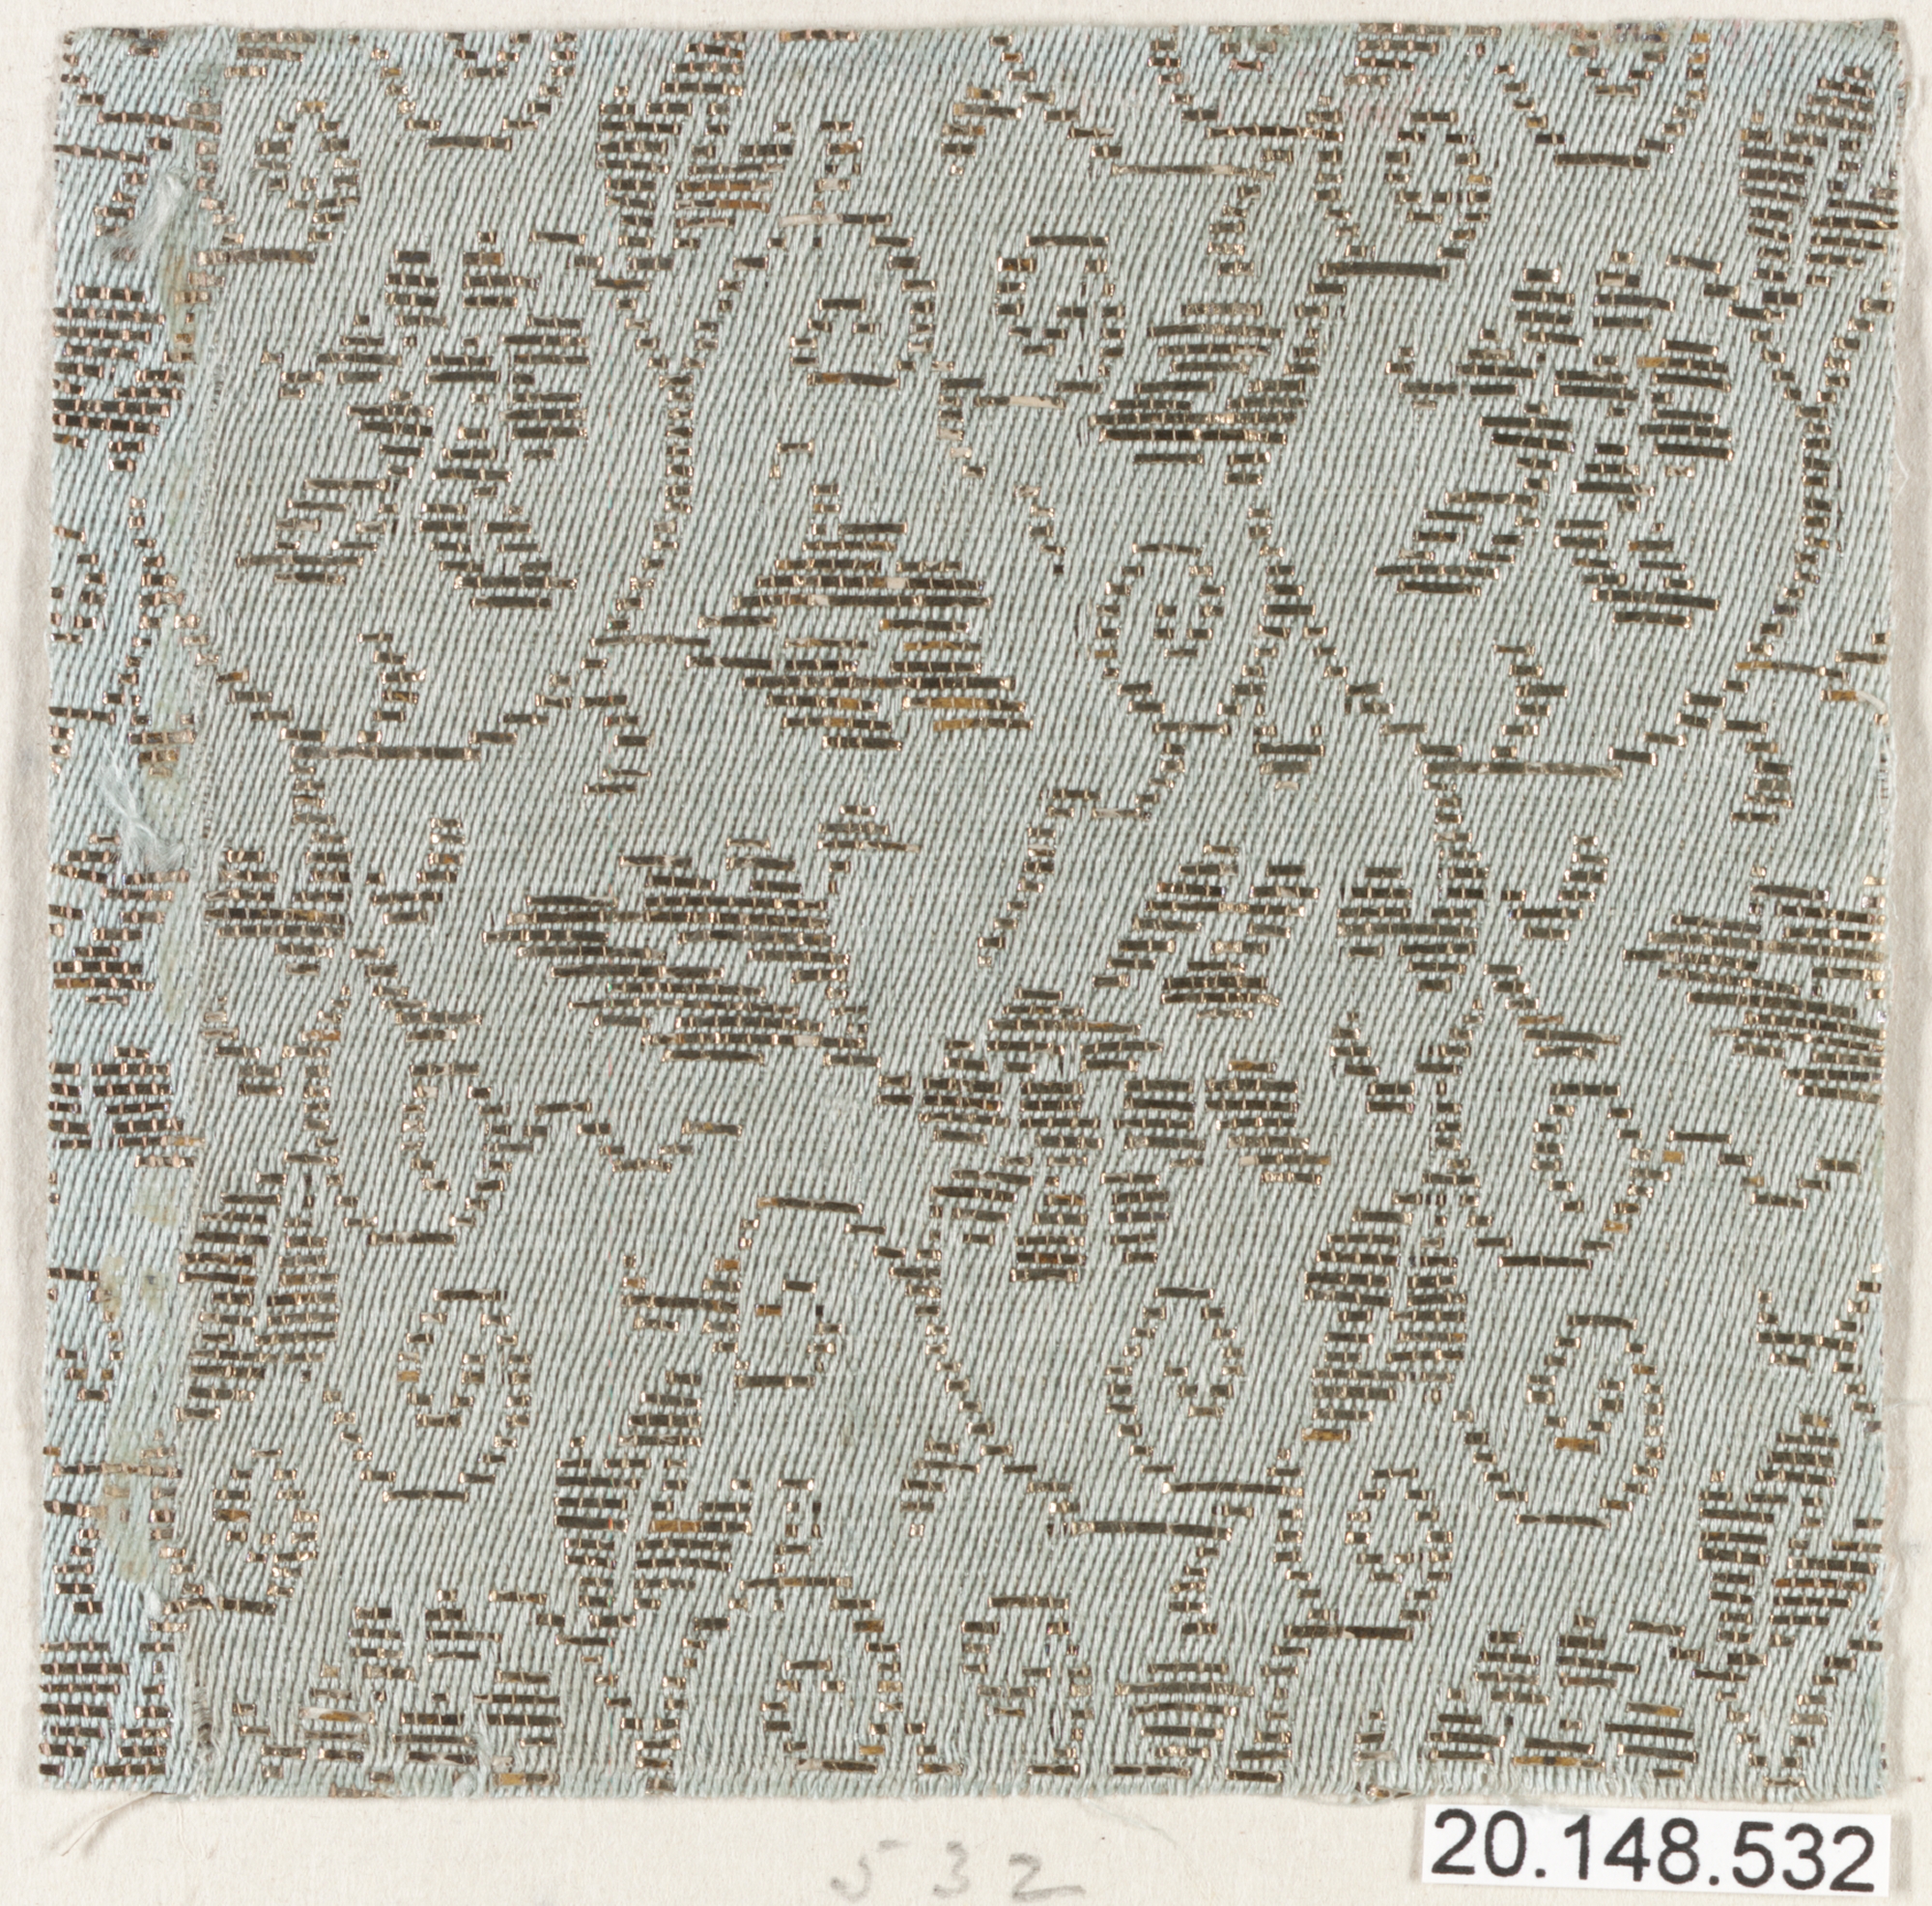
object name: piece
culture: japanese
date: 1701-1800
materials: silk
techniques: compound weave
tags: flowers,leaves